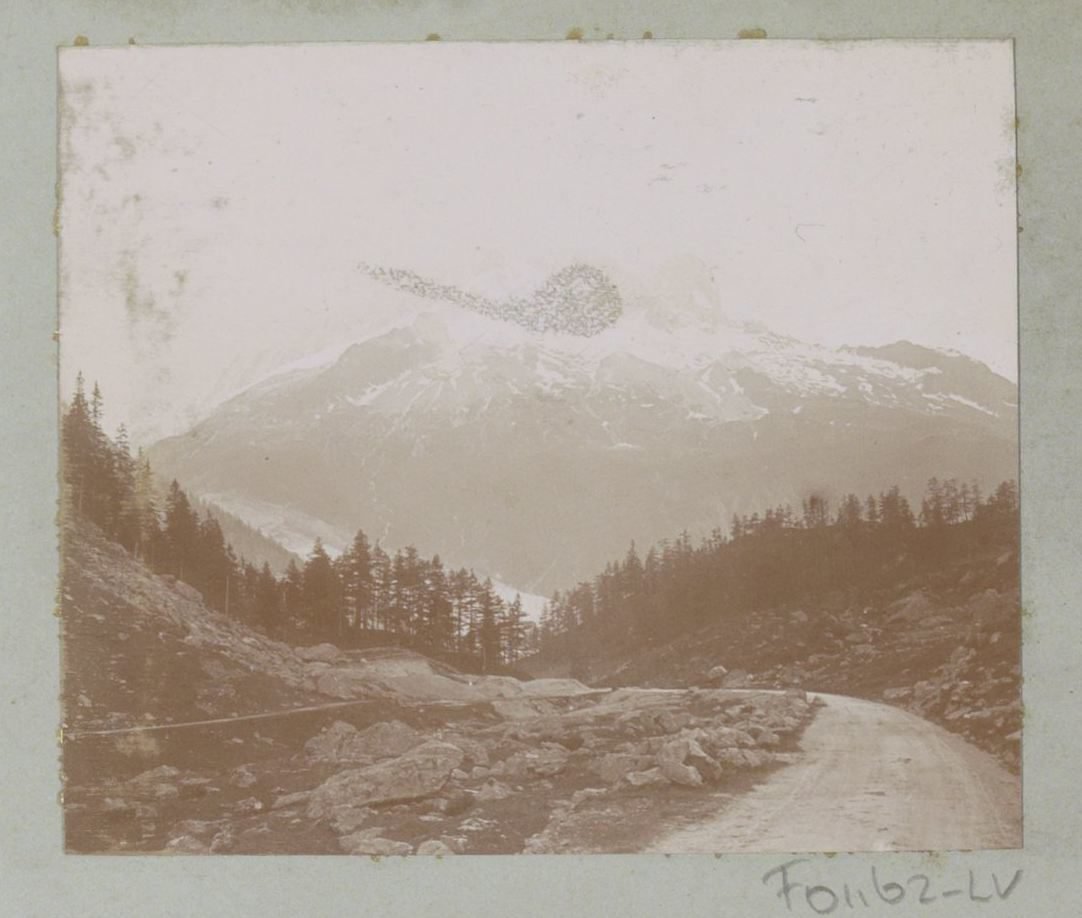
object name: photograph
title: Berglandschap met een weg en besneeuwde bergtoppen in de Alpen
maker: Anonymous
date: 1905-1910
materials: paper, photographic support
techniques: gelatin silver print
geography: alps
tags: road, path, mountains (+ landscape with figures, staffage), mountain-range, snow peaks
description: Onderdeel van Fotoalbum van een Franse amateurfotograaf met bezienswaardigheden in Frankrijk, Zwitserland en Italië.